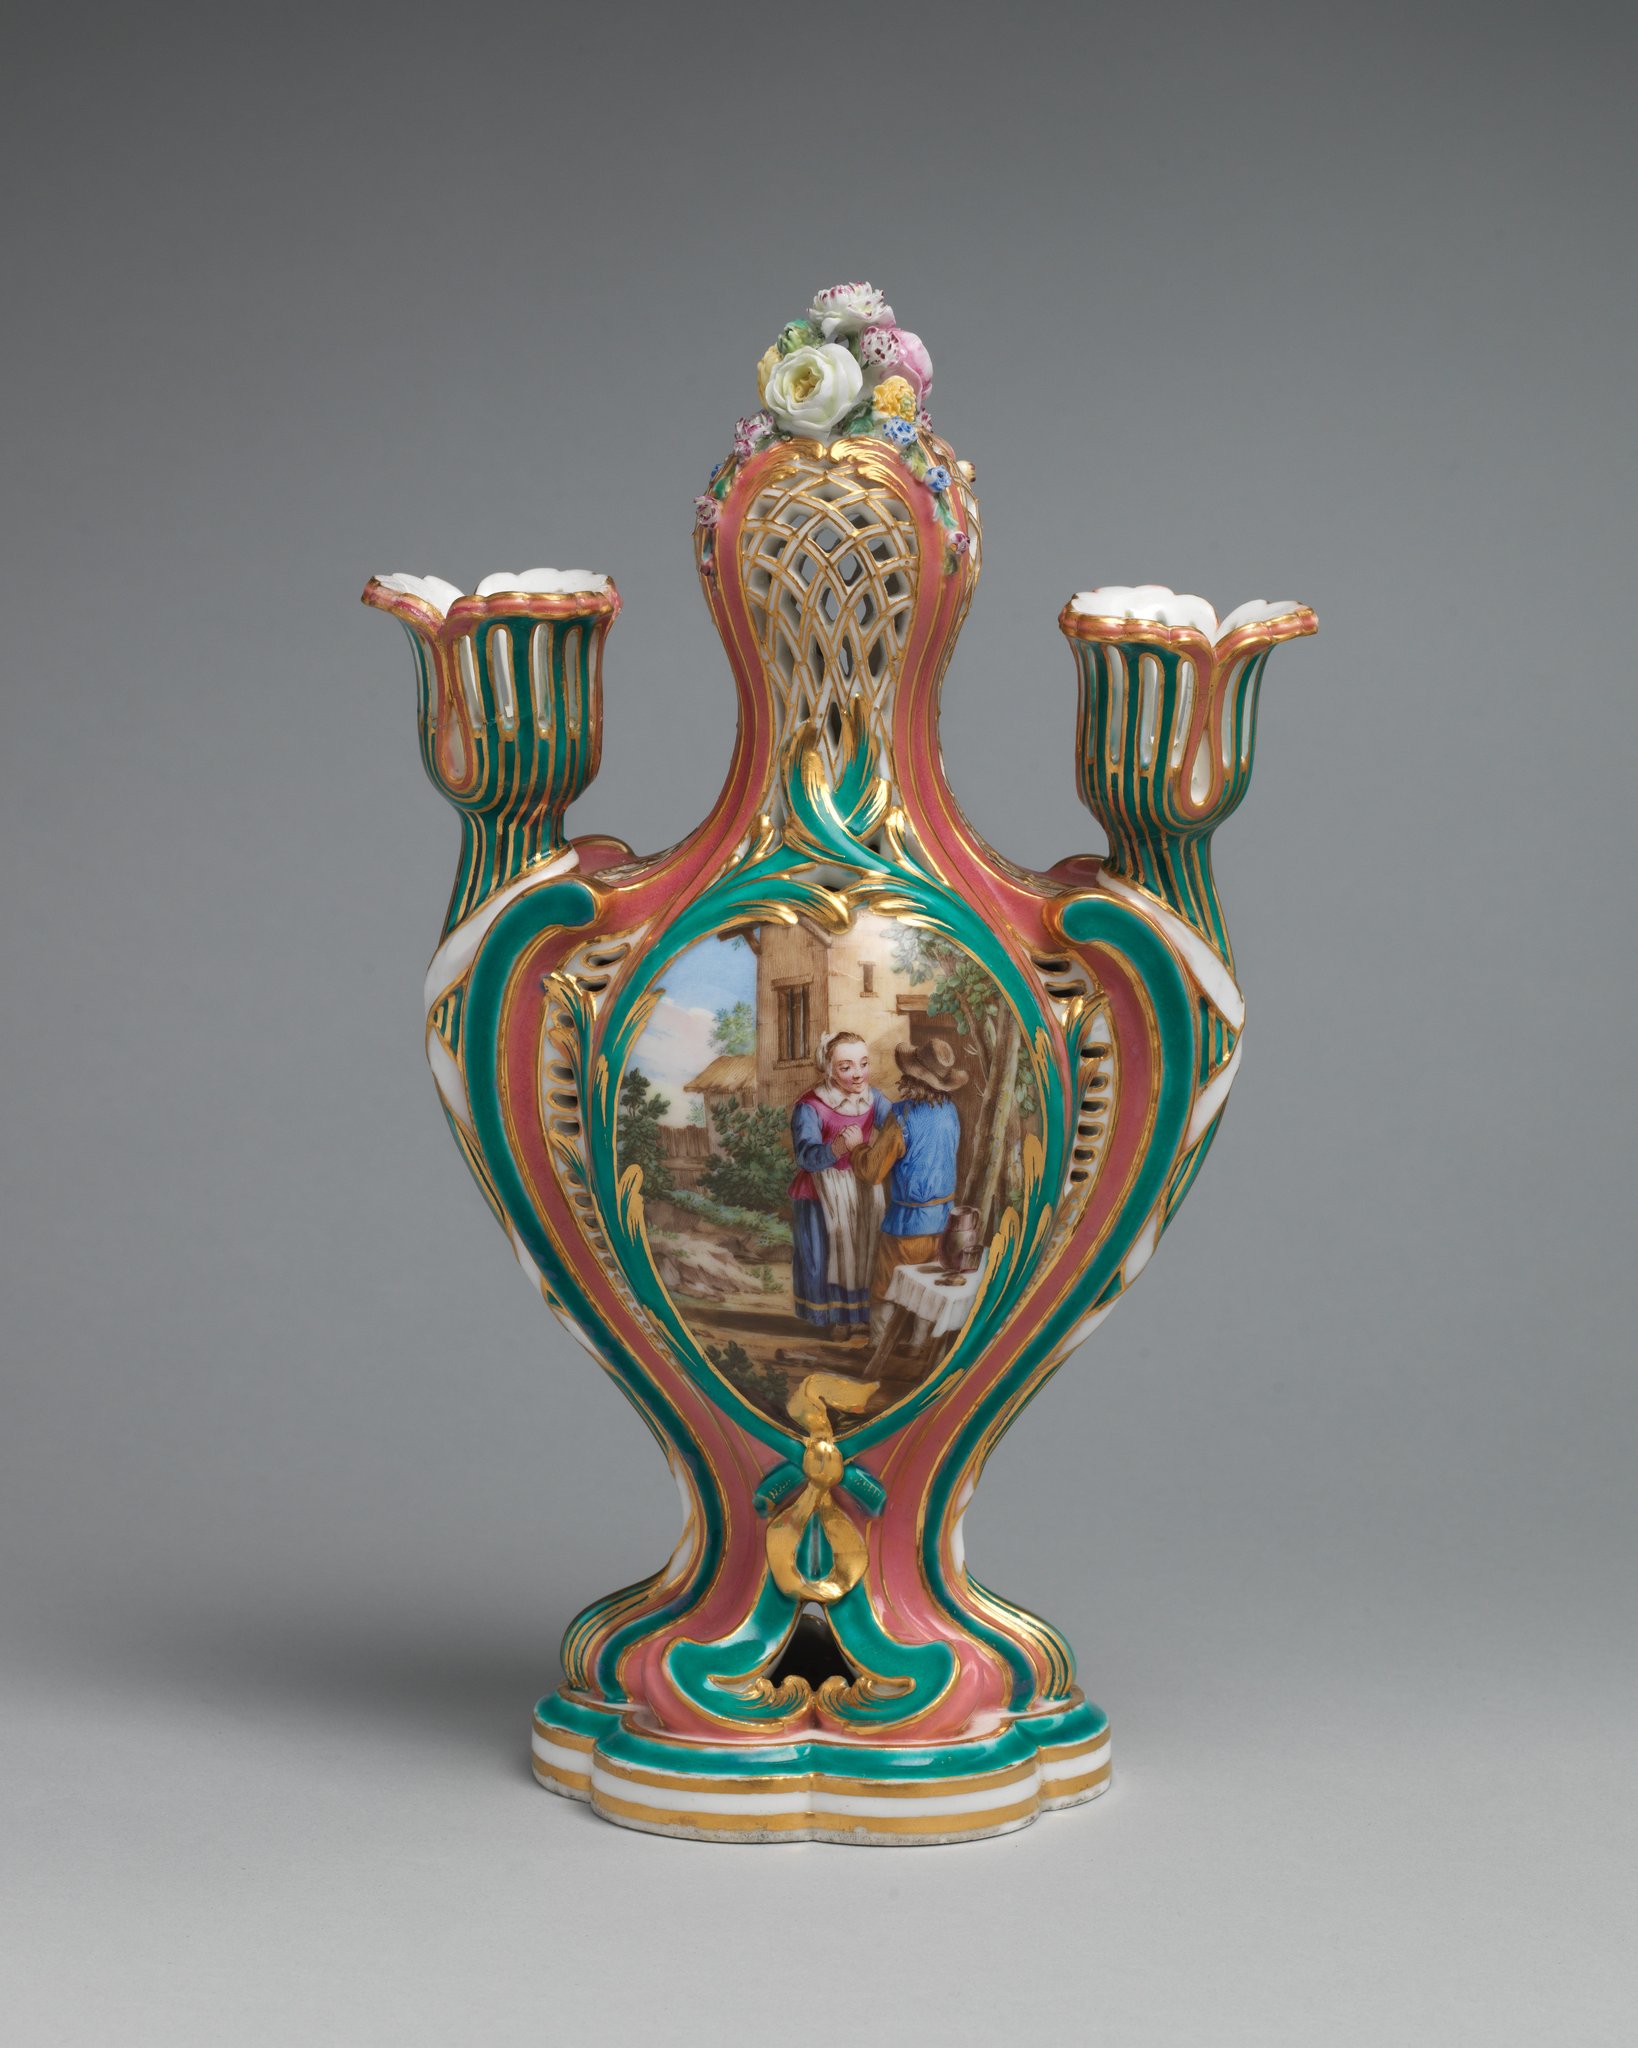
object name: potpourri vase with candleholders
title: Potpourri vase with candleholders (pot-pourri à bobêche) (one of a pair)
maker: sèvres manufactory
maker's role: manufactory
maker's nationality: french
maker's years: 1740-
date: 1759-1760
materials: soft paste porcelain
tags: men,women